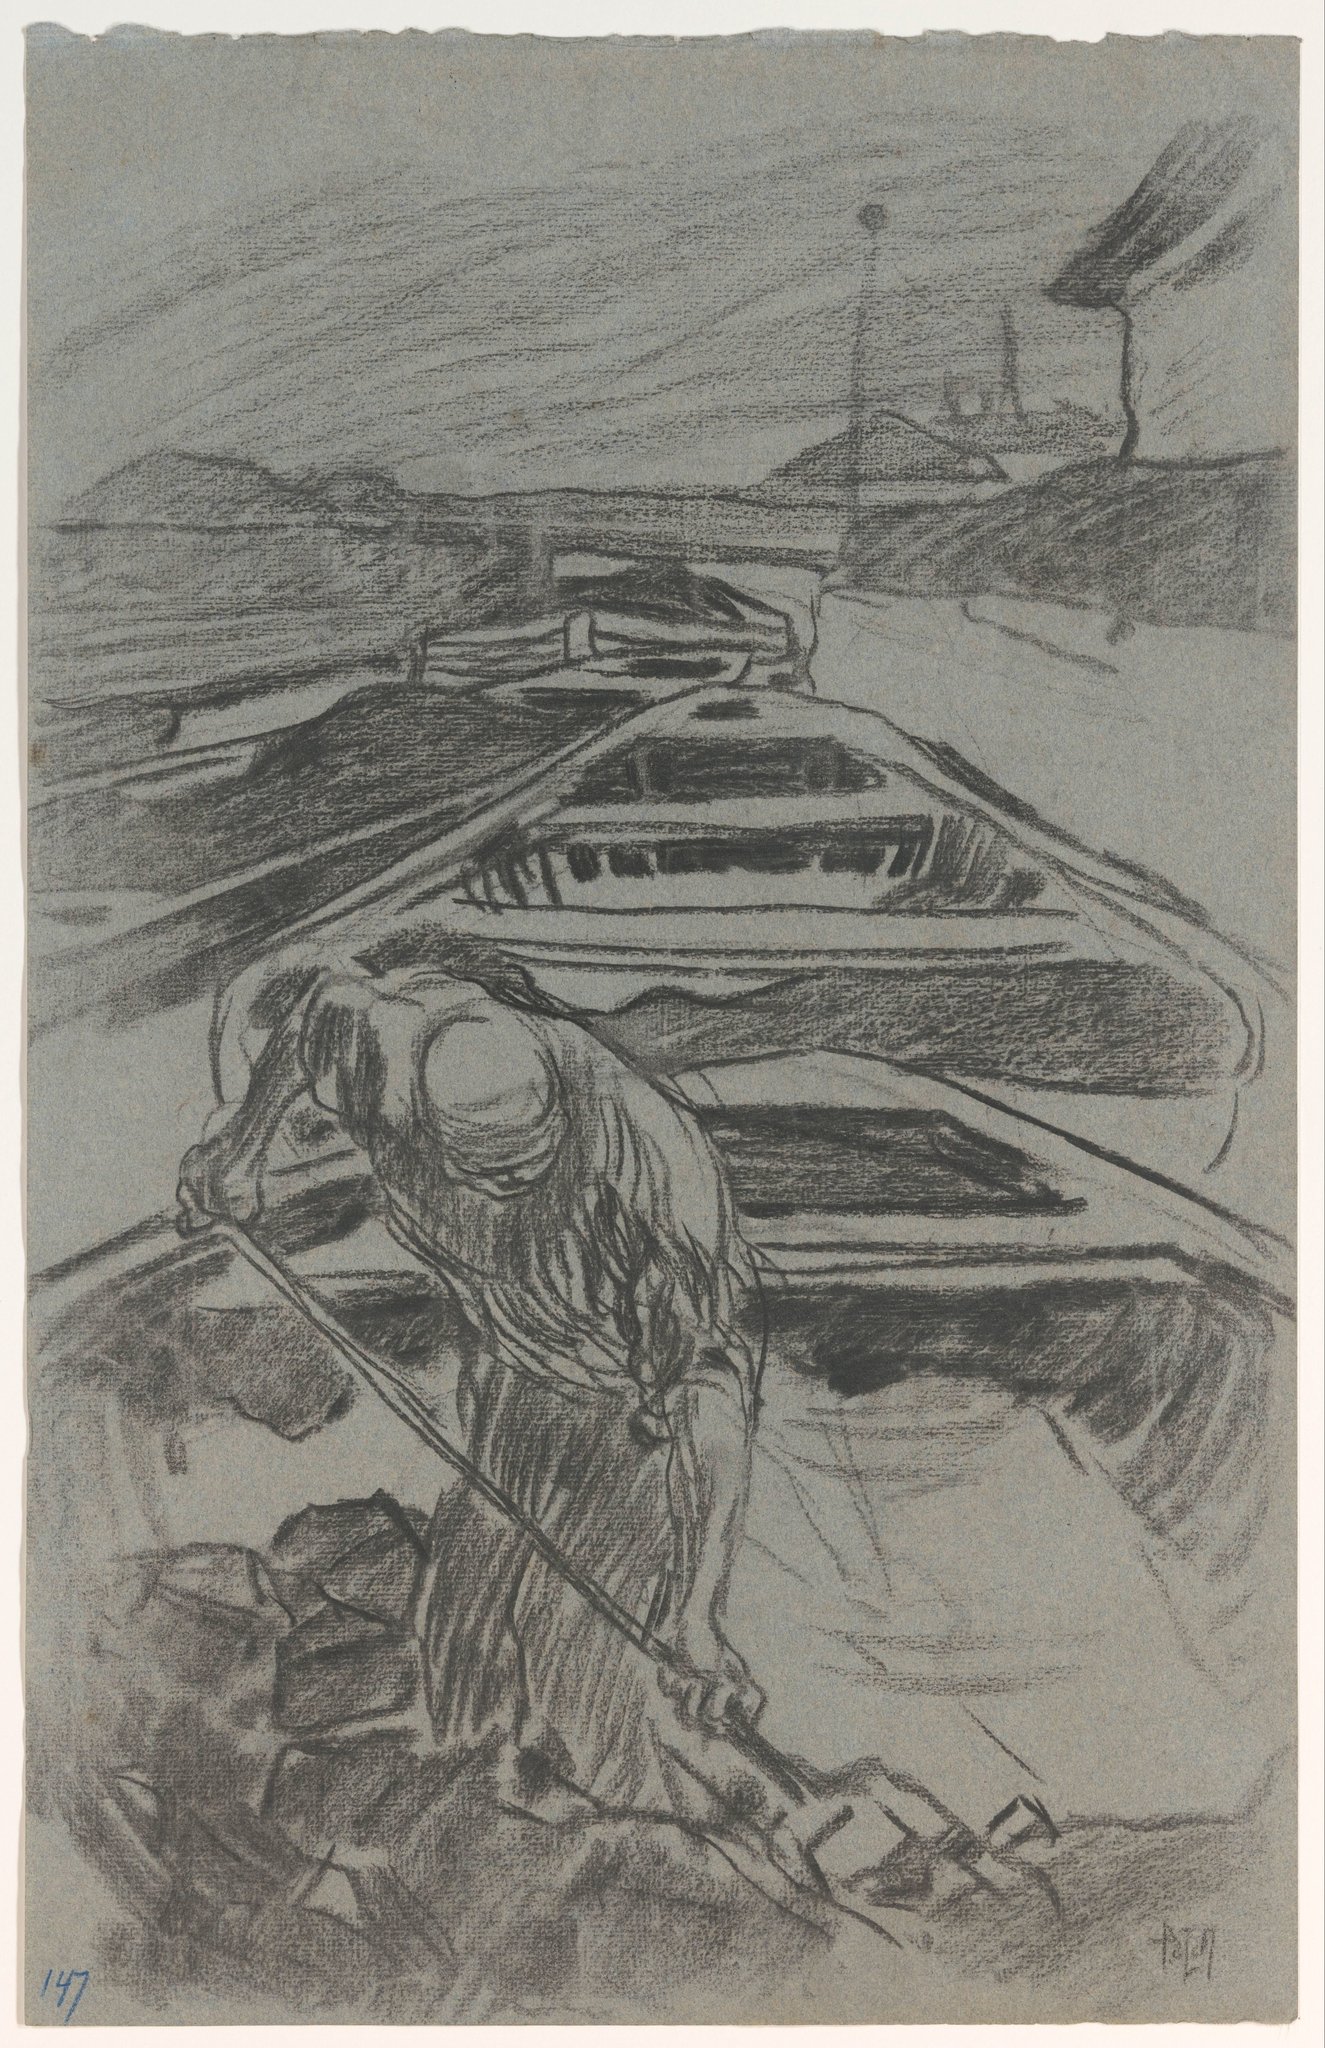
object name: drawing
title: Arbeider in steenkoolschuit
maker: pieter de josselin de jong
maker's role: draughtsman, painter, print maker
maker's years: 1861-1906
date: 1871-1906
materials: chalk, paper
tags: anthracite, hard coal, ships (in general)